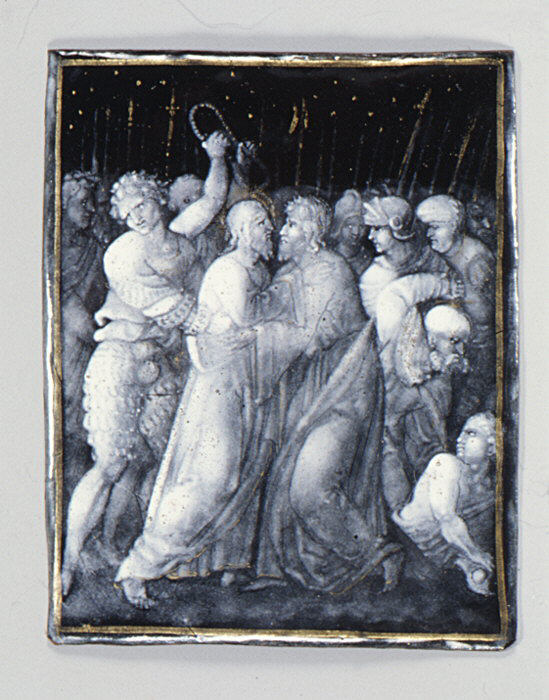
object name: plaque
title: The Betrayal (one of seven)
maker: jean ii pénicaud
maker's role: enameler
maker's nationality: french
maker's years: 1524-1554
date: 1534-1566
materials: copper, enamel, gilt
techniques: painting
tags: christ,crowd